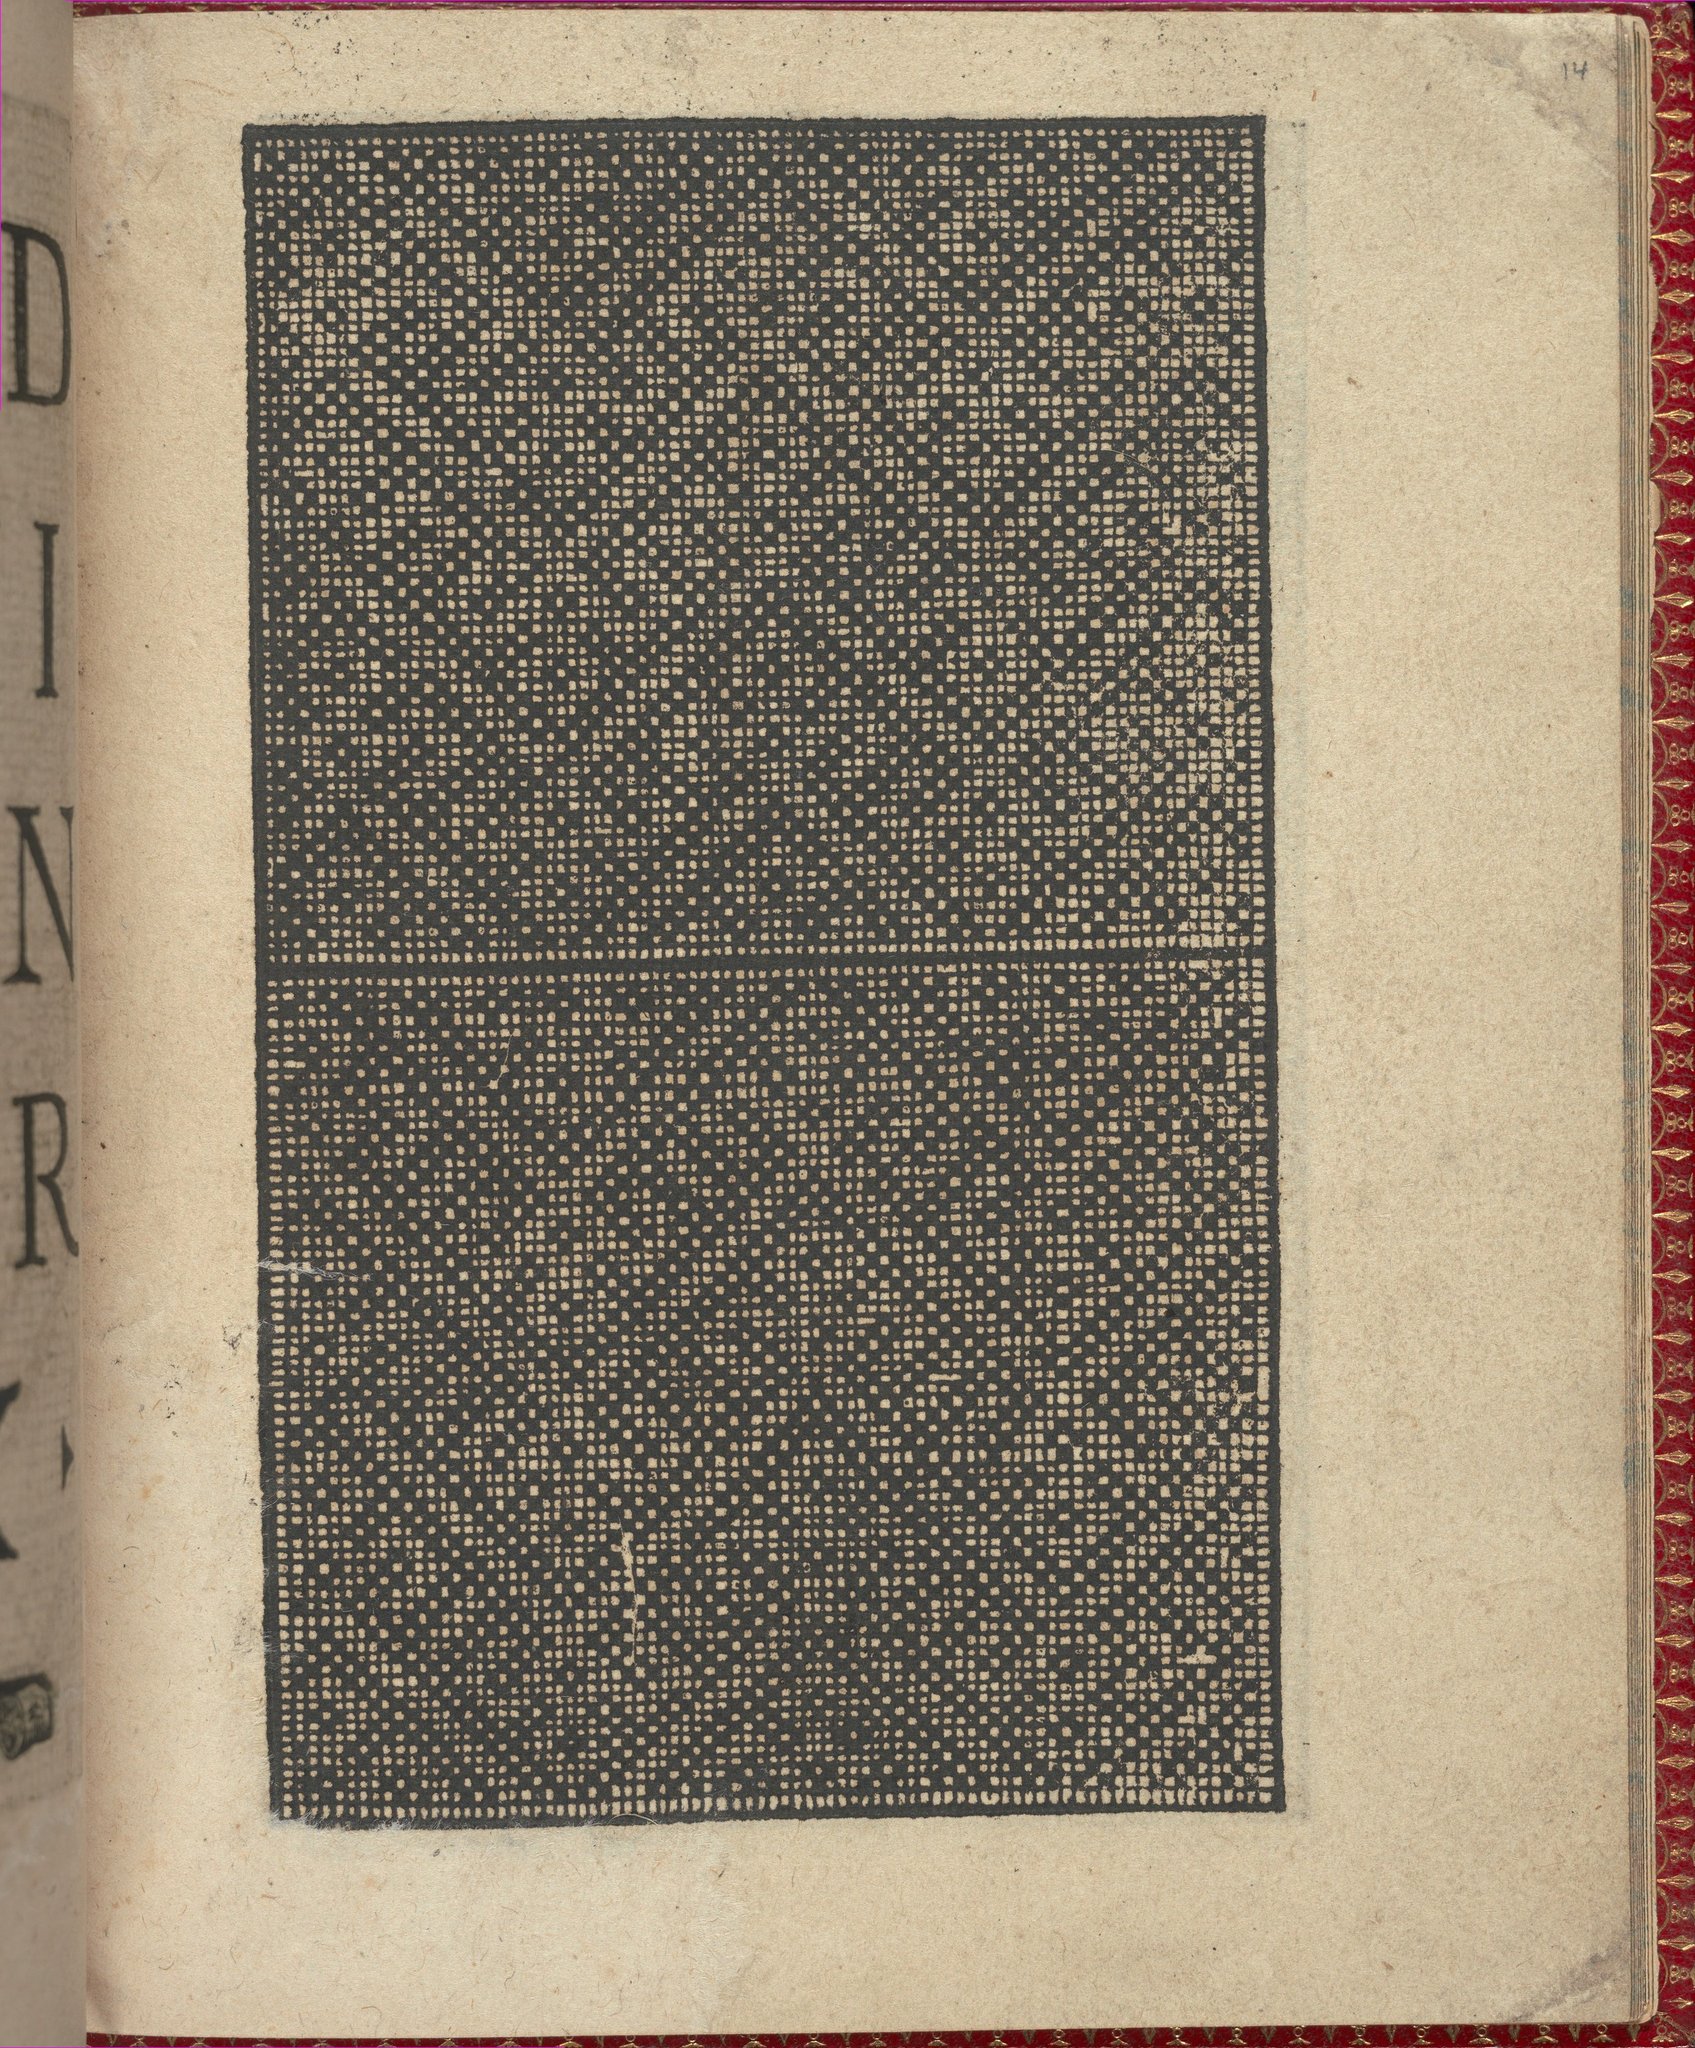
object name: book print ornament architecture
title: Ce est ung tractat de la noble art de leguille ascavoir ouvraiges de spaigne... page 14 (recto)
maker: willem vosterman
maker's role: printer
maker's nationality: netherlandish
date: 1527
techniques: woodcut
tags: ornament